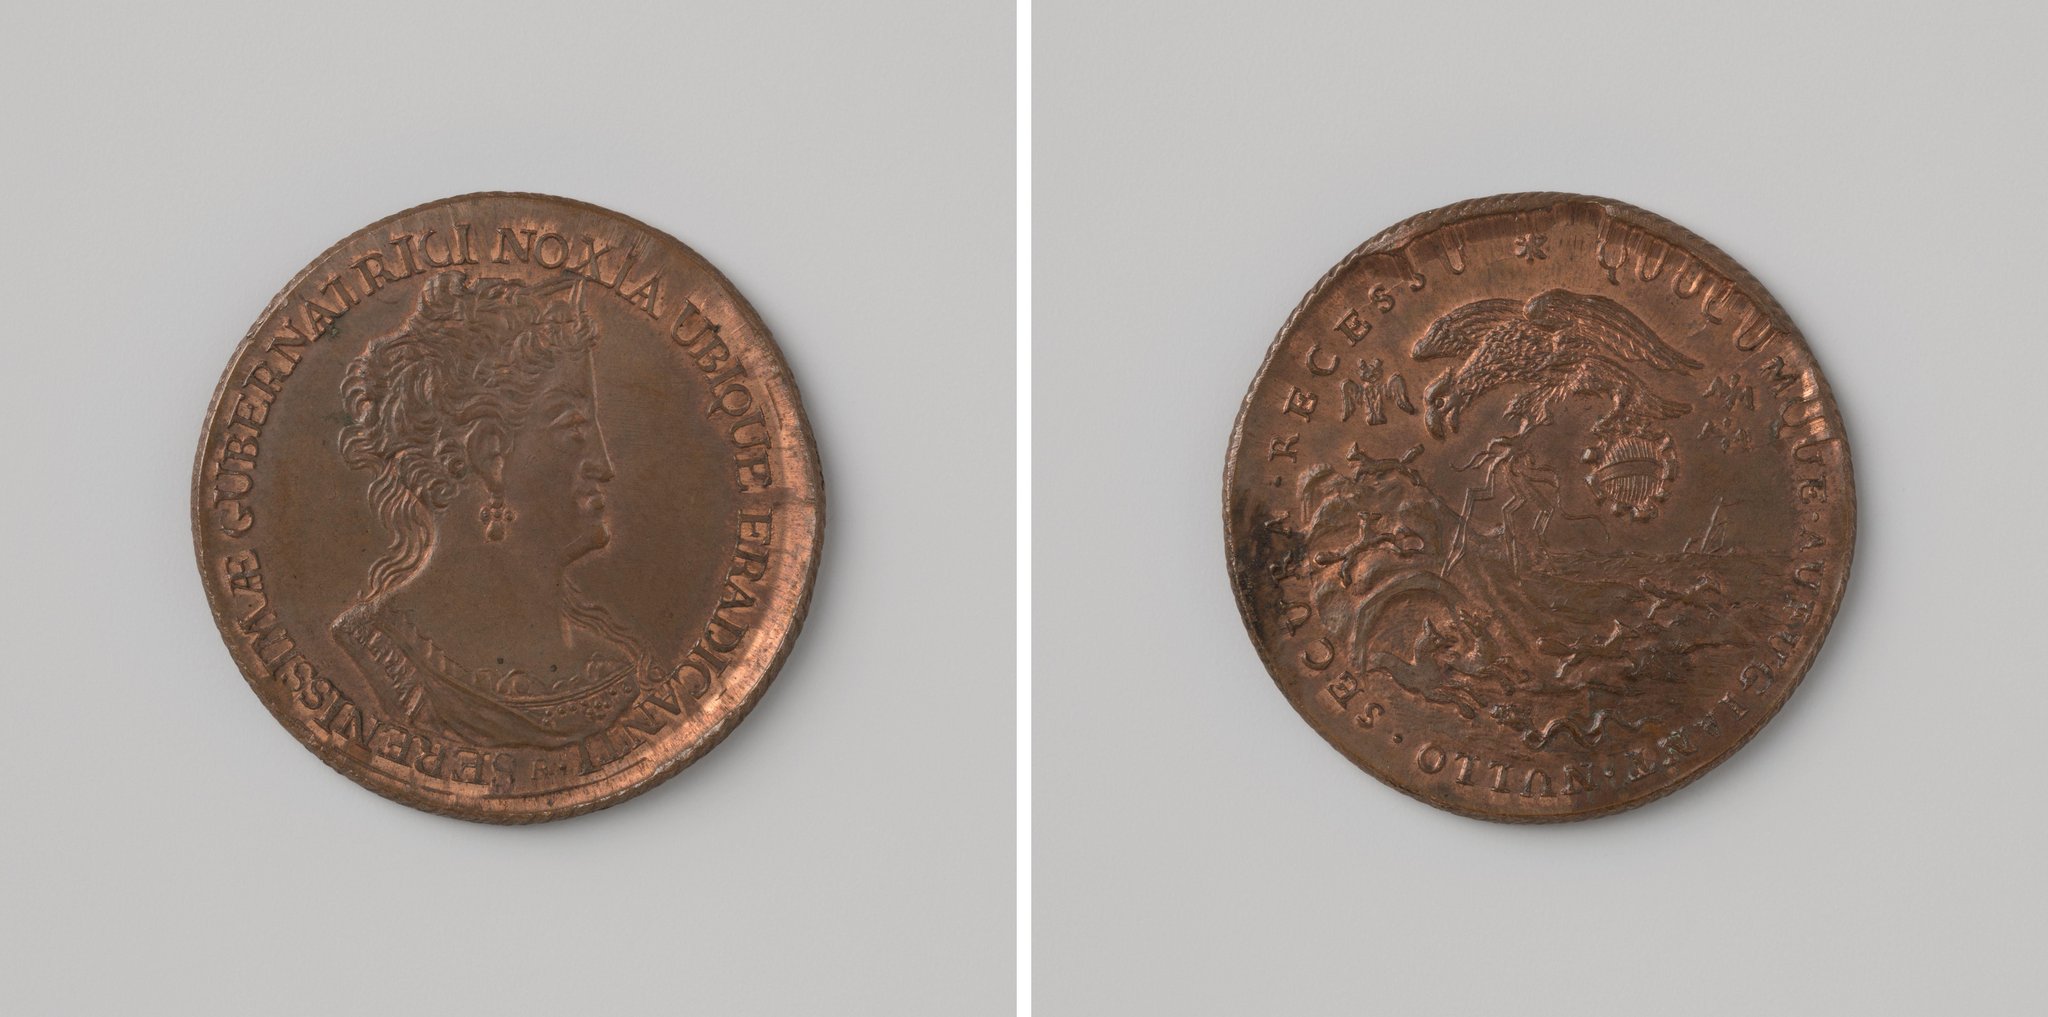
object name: new year medal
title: Maria Elisabeth, landvoogdes der zuidelijke Nederlanden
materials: copper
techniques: striking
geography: antwerp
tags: maria elisabeth (aartshertogin van oostenrijk)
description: Koperen penning. Voorzijde: borststuk vrouw met diadeem binnen omschrift. Keerzijde: arend met in zijn klauwen bliksem en wapenschild valt een grot aan, waaruit vossen, slangen en ander gedierte vlucht, op achtergrond schip op zee binnen omschrift